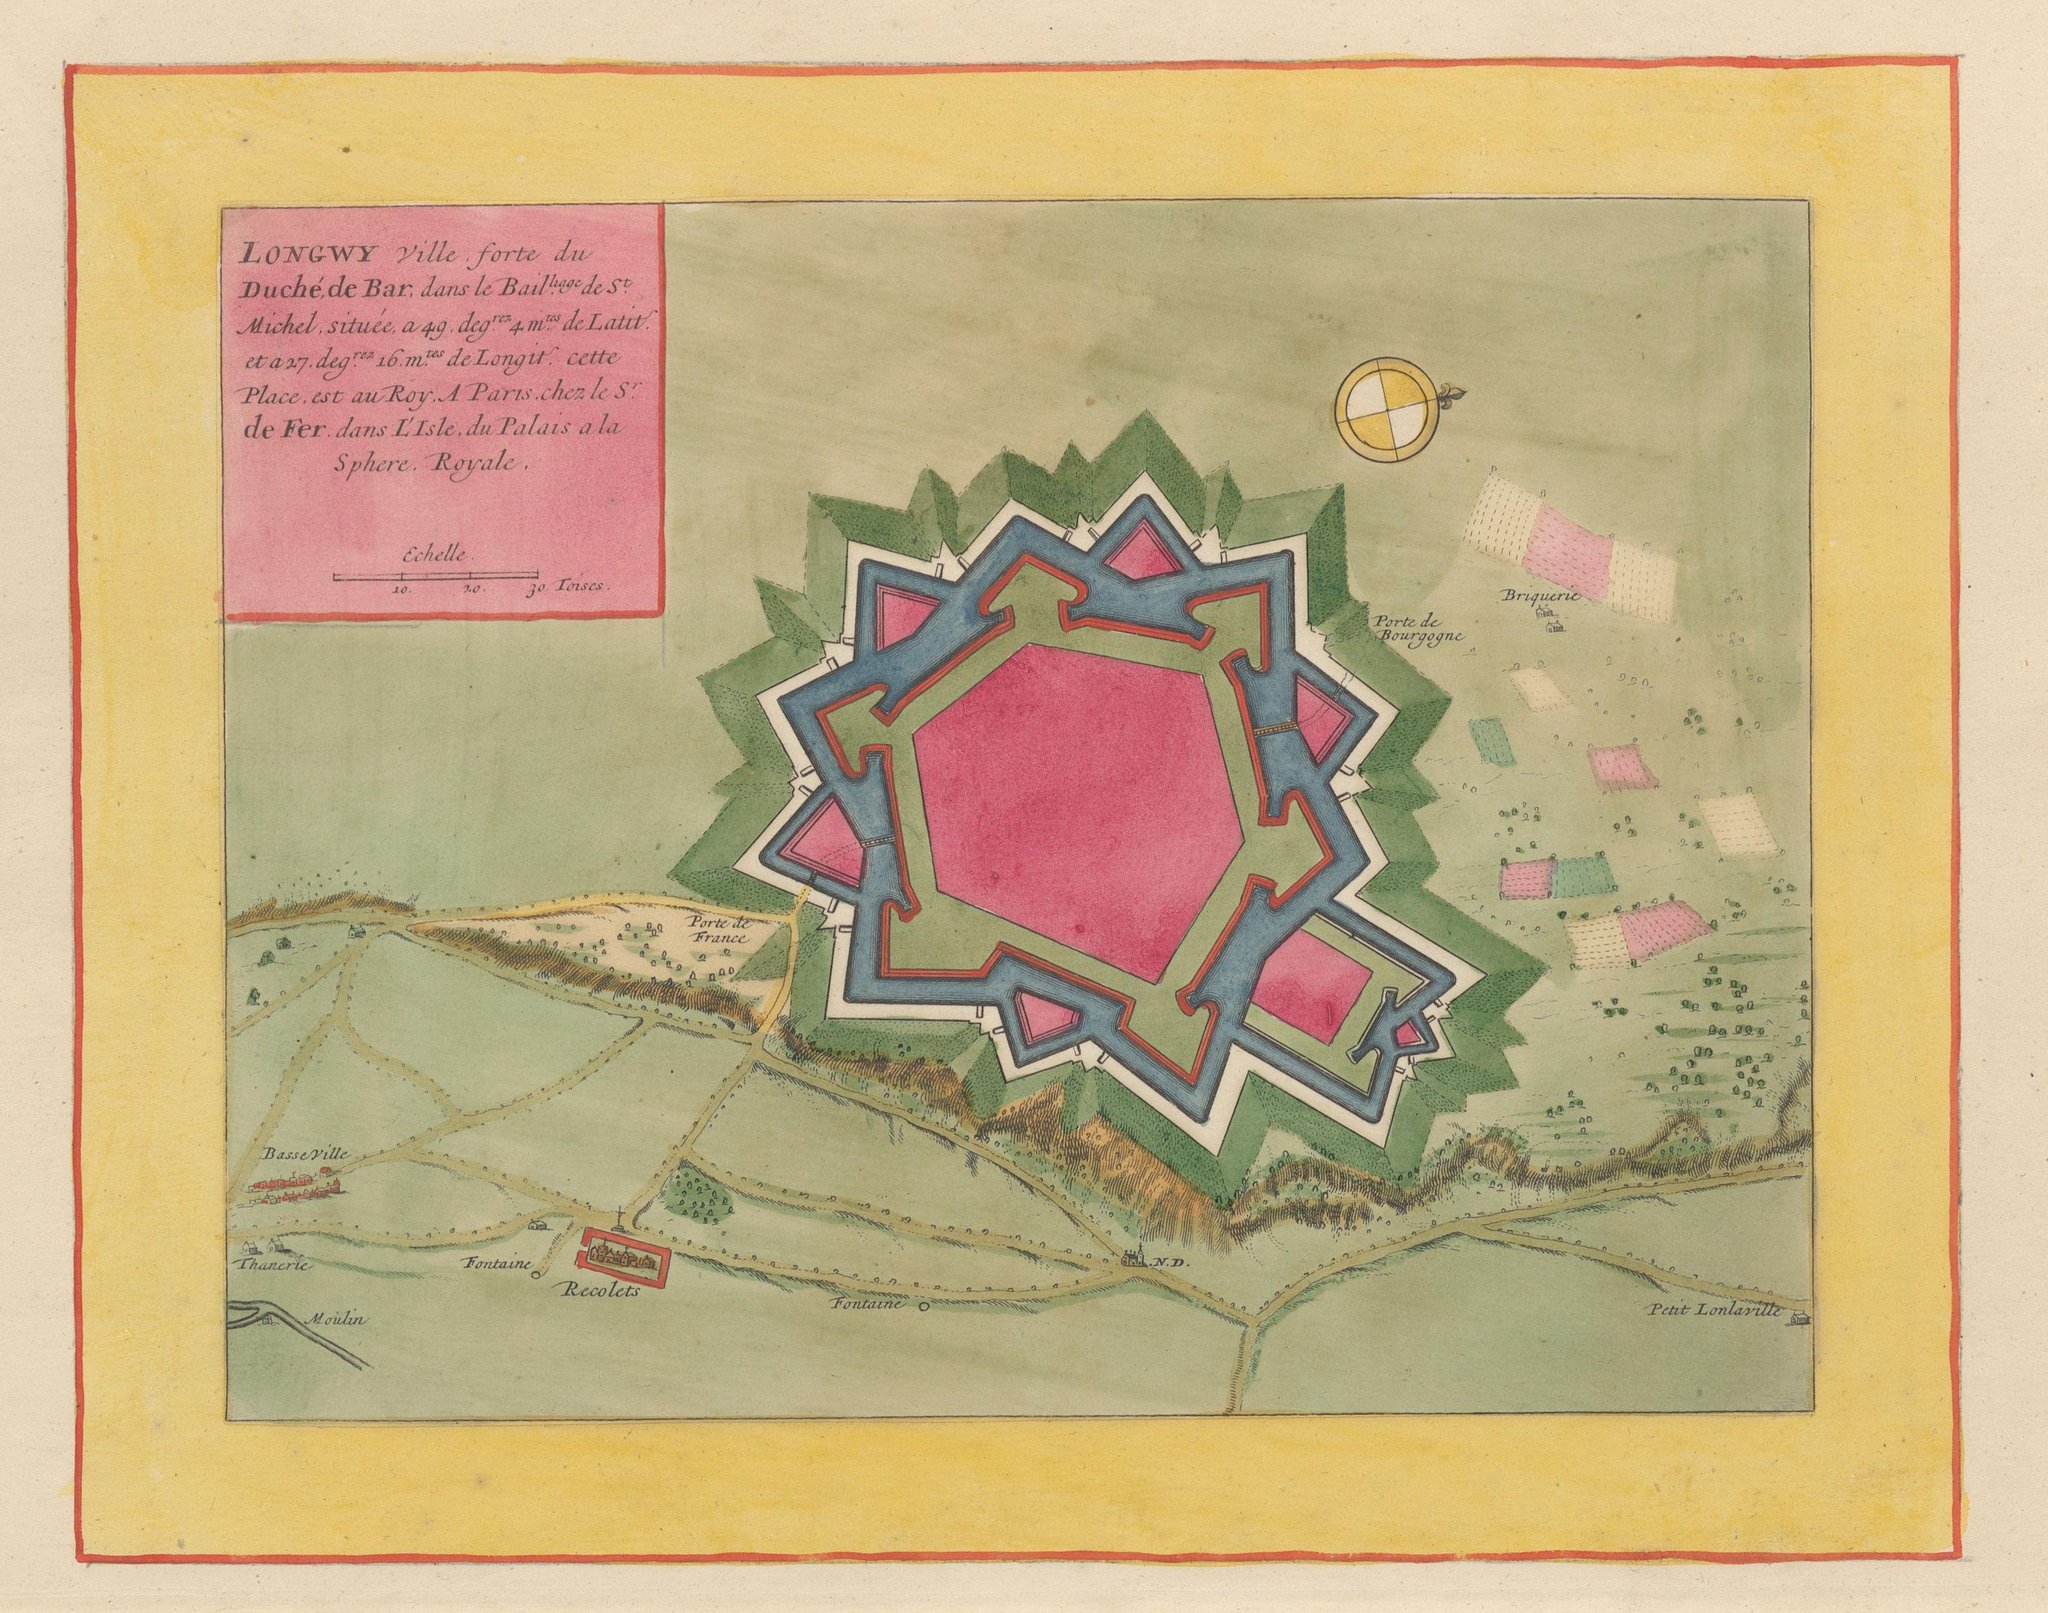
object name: album leaf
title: Longwy, ville forte du duché de Bar (...)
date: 1690-1702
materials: paper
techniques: engraving, hand coloring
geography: the hague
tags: maps of cities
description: Deze kaart is in een aantal atlassen gebruikt. Onder andere in: Mortier, Pieter. Les forces de l'Europe. Parijs: Nicolas de Fer, 1690-1695, en in: Fer, Nicolas de. Le theatre de la guerre, dans les Pays-Bas. Amsterdam: Pieter Mortier, ca. 1700, evenals de editie van 1702 van ditzelfde boek. Zie literatuur voor details.